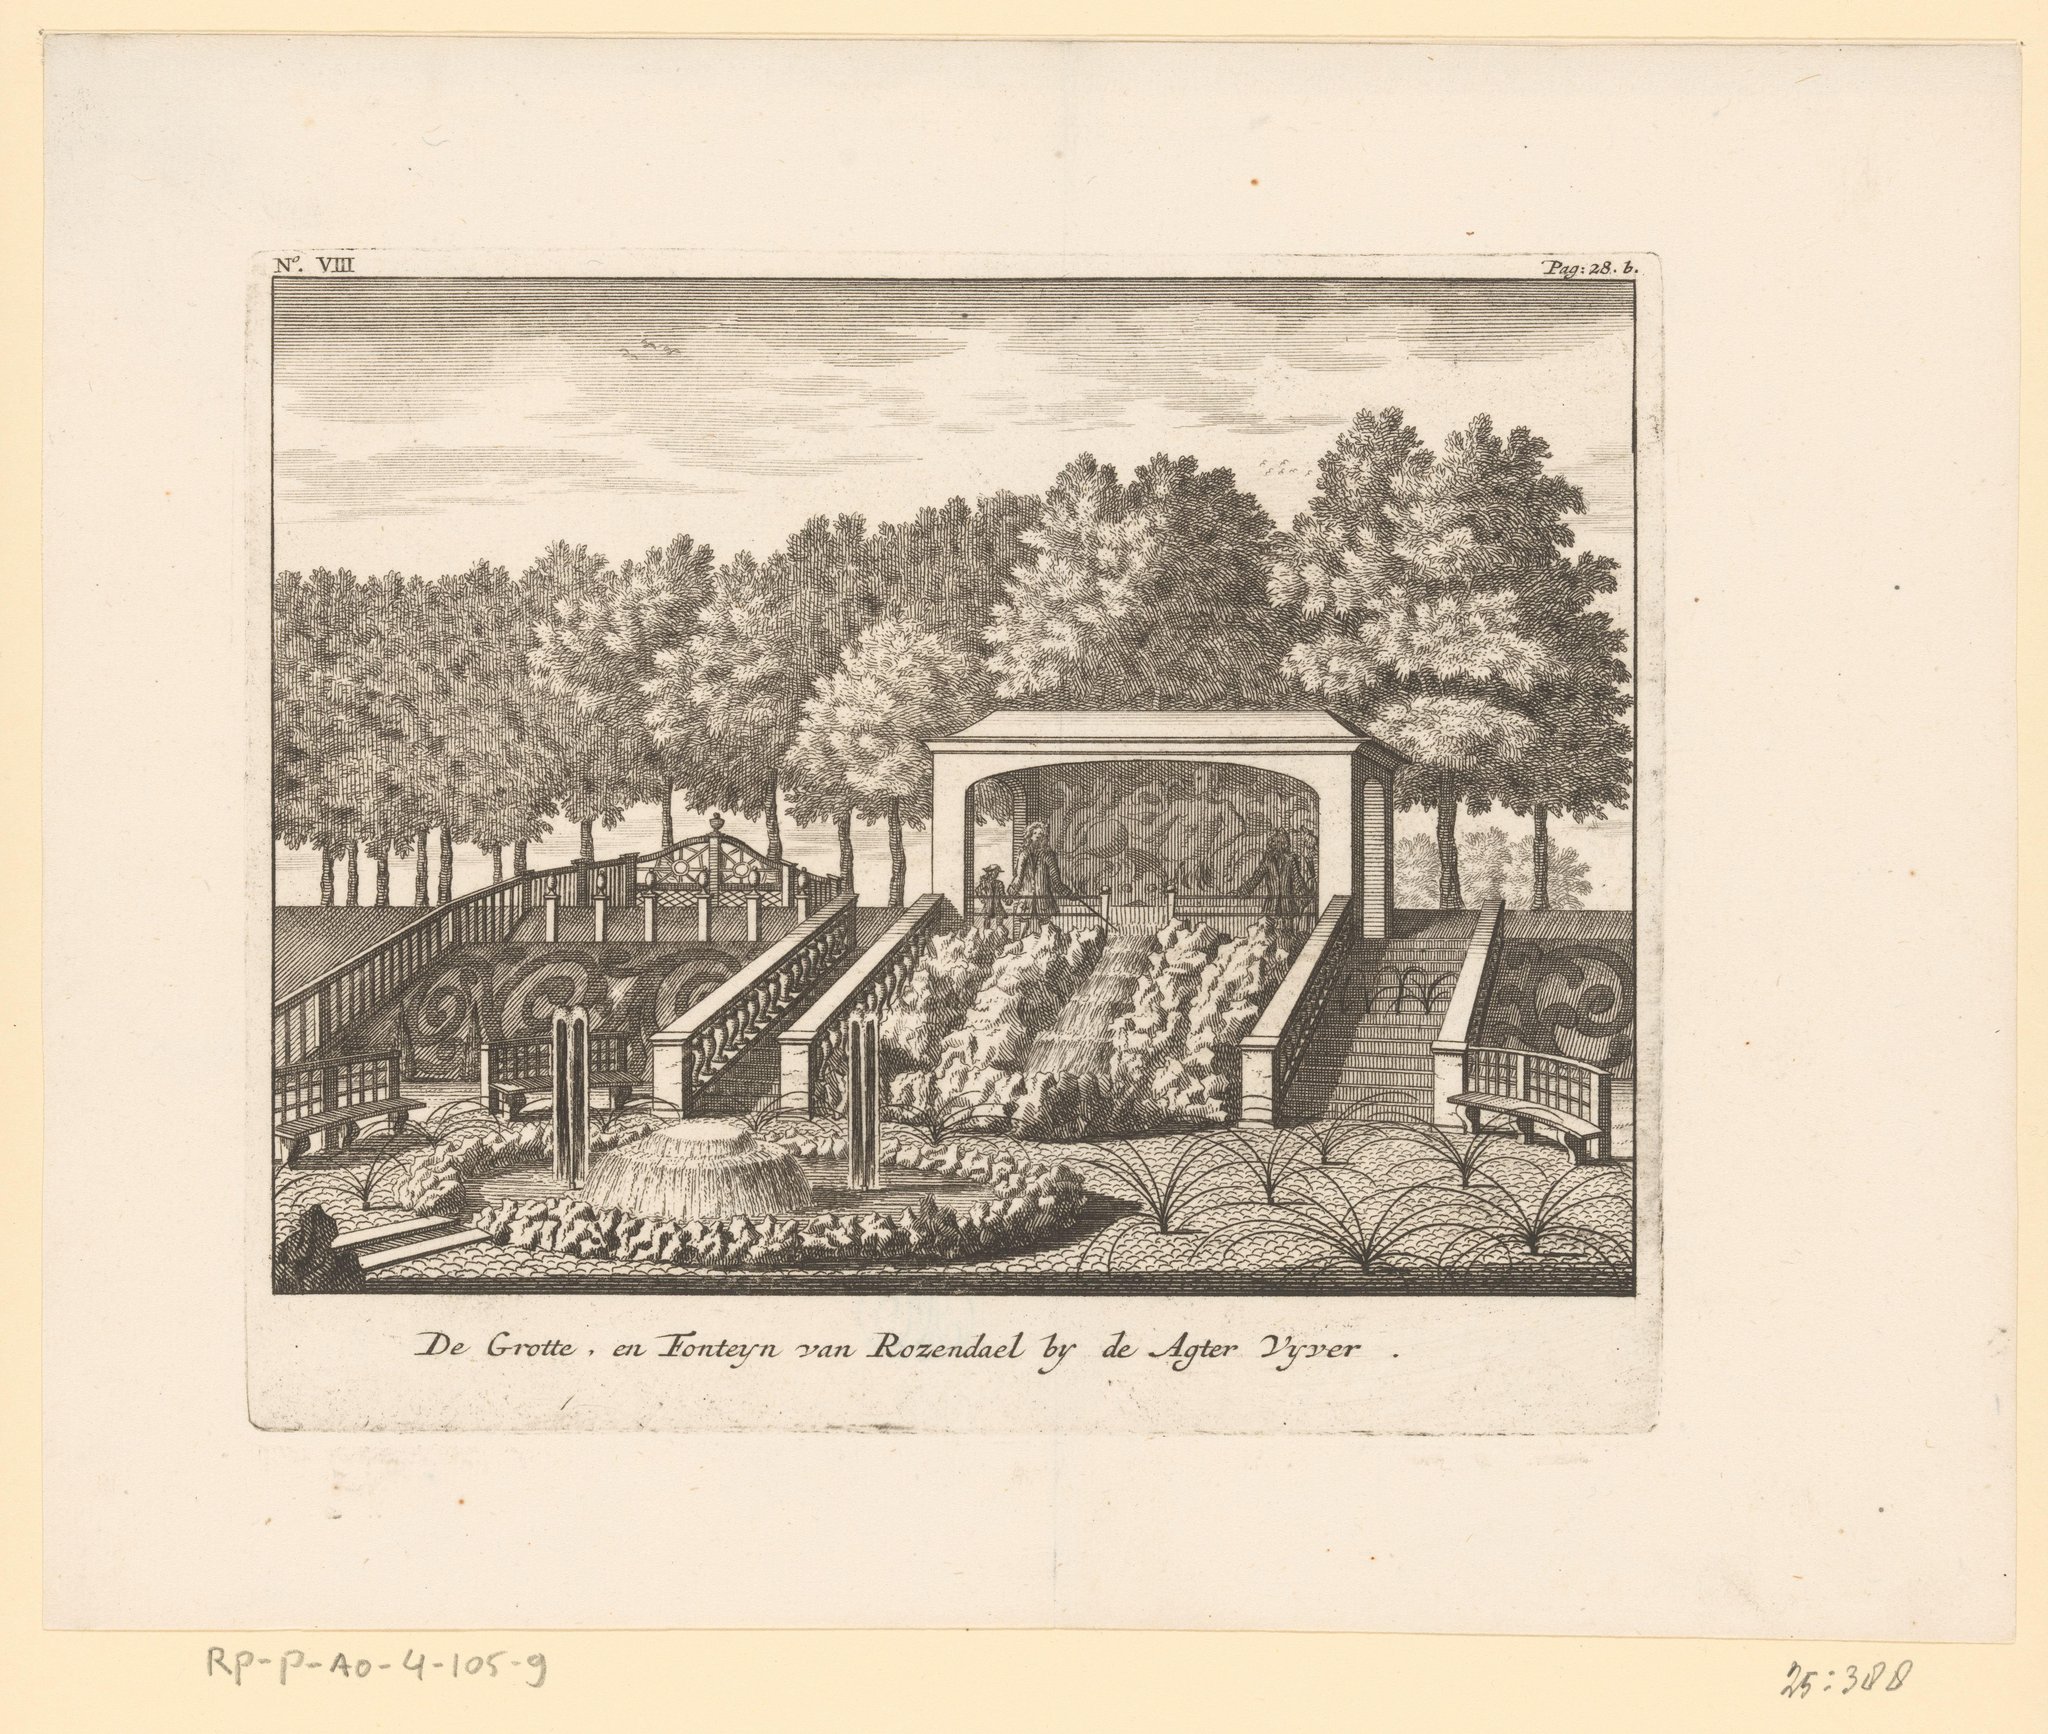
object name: print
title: De grotte, en fonteyn an Rozendael by de agter vyver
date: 1718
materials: paper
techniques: engraving, etching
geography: amsterdam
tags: (story of) neptune (poseidon), castle, garden fountain, french or architectonic garden; formal garden, garden pond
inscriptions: collector's mark: Lugt 195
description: Gezicht op de grot en de fontein bij de achtervijver van Kasteel Rosendael. Boven de cascade het kabinet van Neptunes. Linksboven genummerd: VIII. Rechtsboven gemerkt: Pag: 28b.